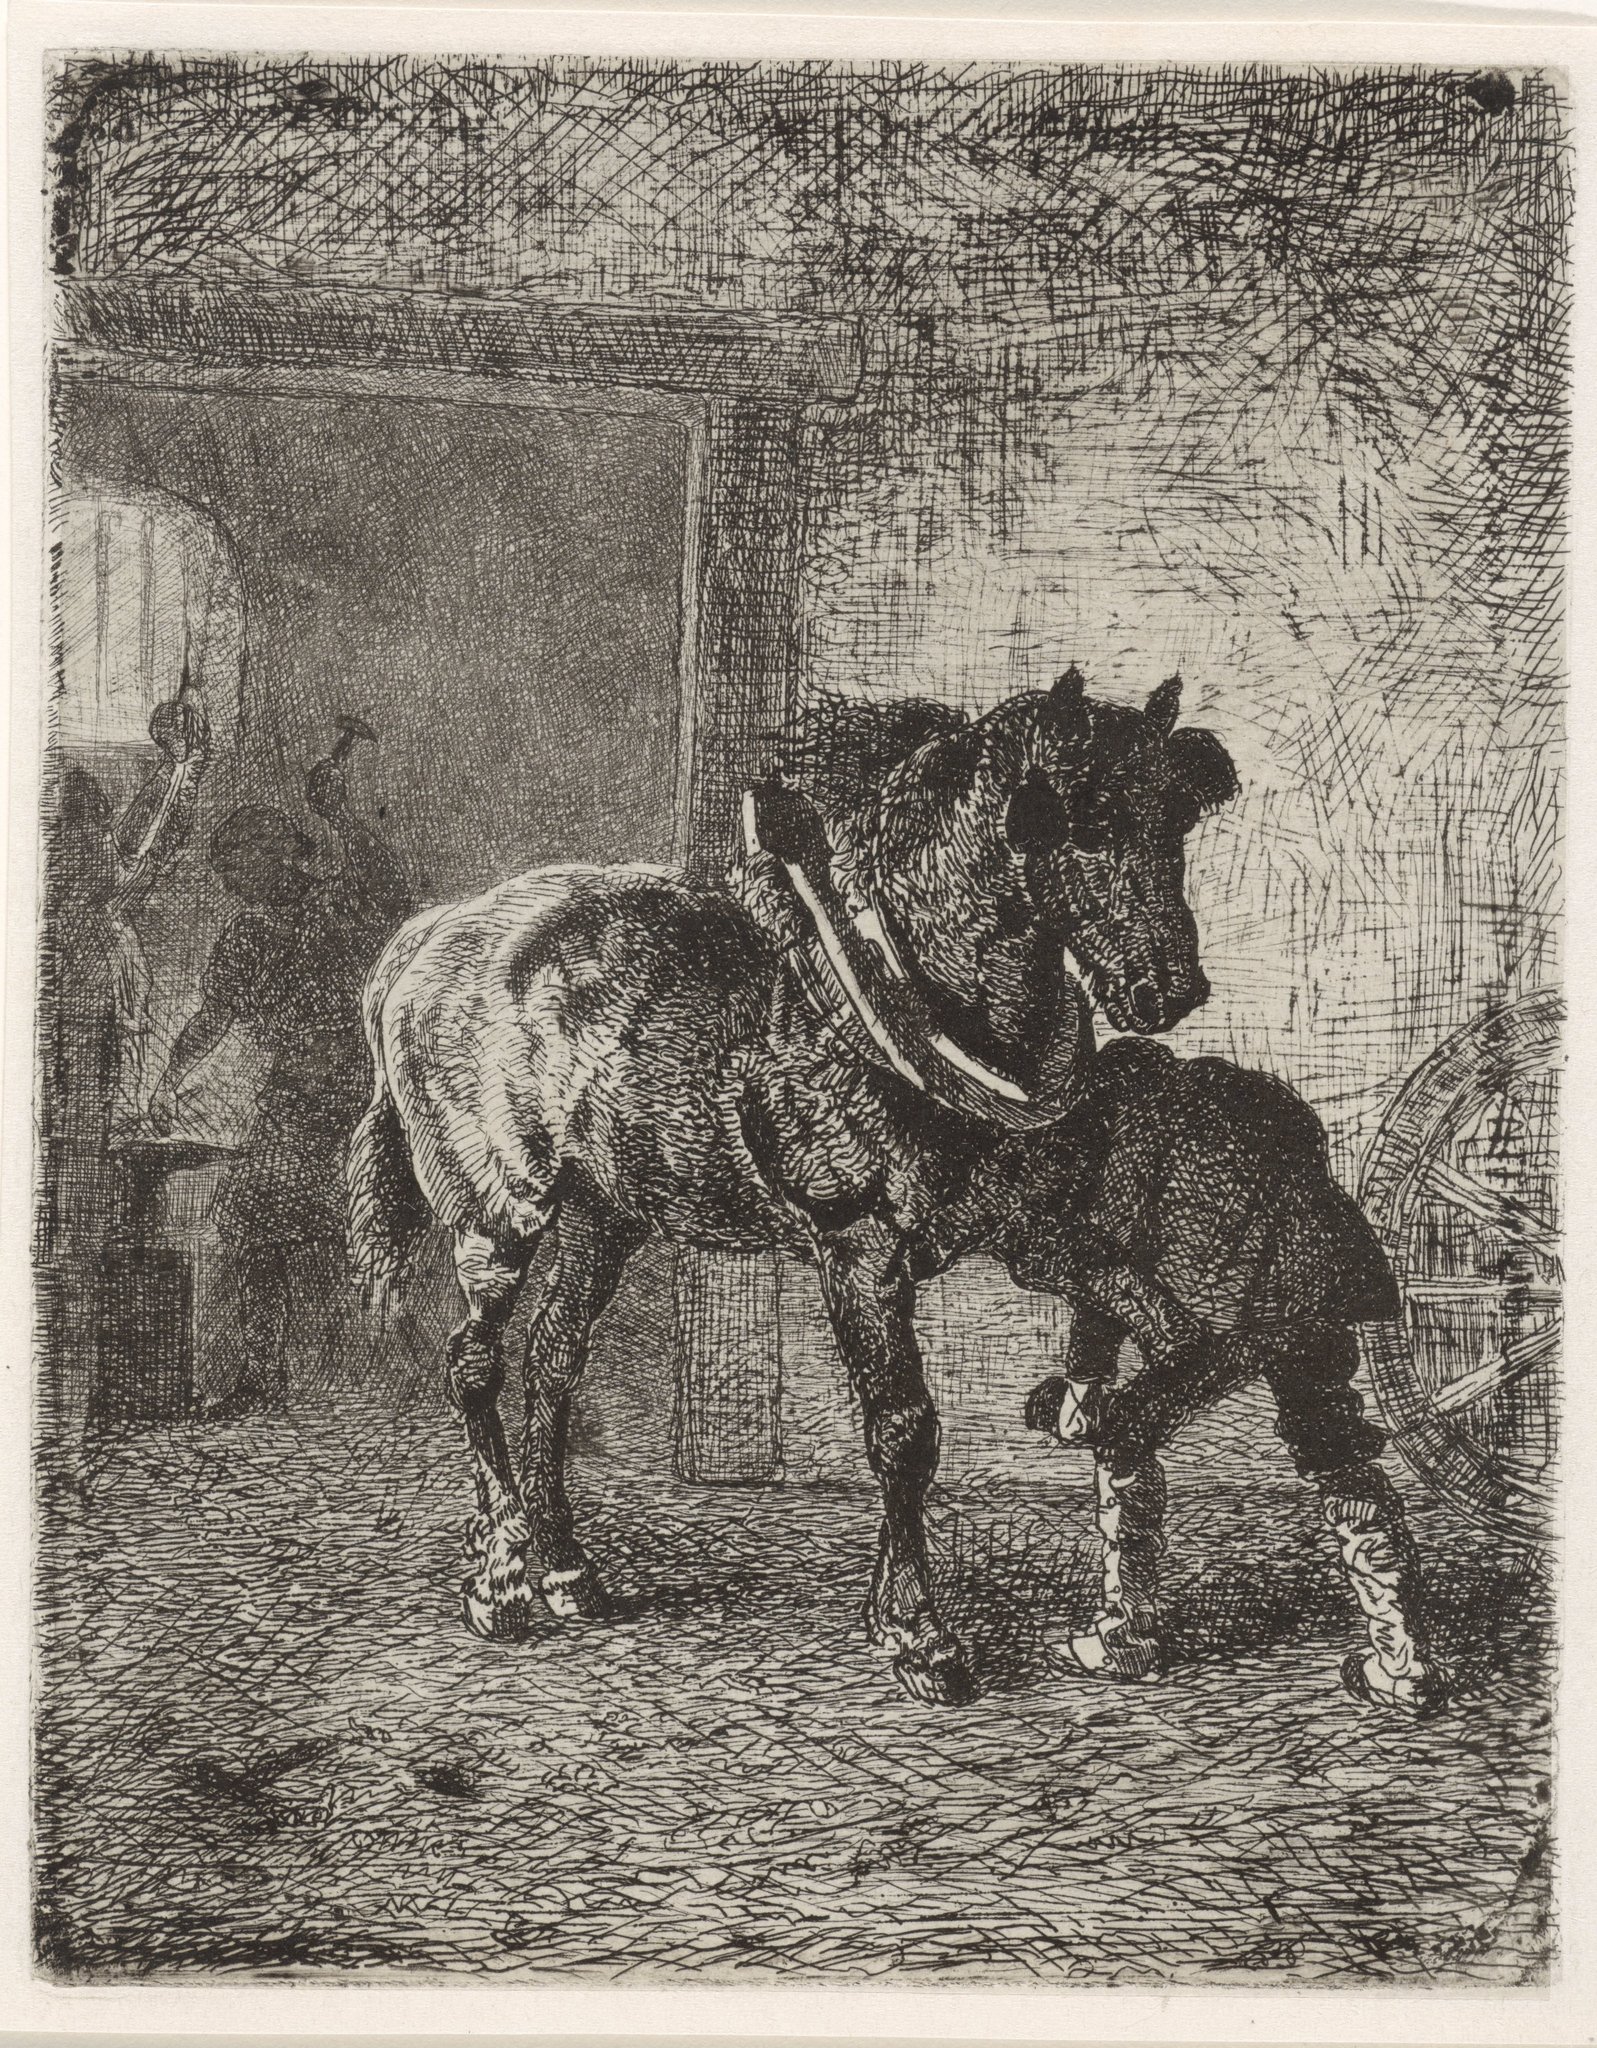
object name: print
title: Paard krijgt hoefijzers in een smederij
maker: cornelis albertus johannes schermer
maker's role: draughtsman, painter, print maker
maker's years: 1824-1915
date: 1839-1915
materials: paper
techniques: etching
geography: the hague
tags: farrier, shoeing-smith, horse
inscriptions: collector's mark: Lugt 2228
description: Vooraan beslaat een man de hoef van een paard. Achter hem is een smid in een smederij aan het werk bij een aambeeld.